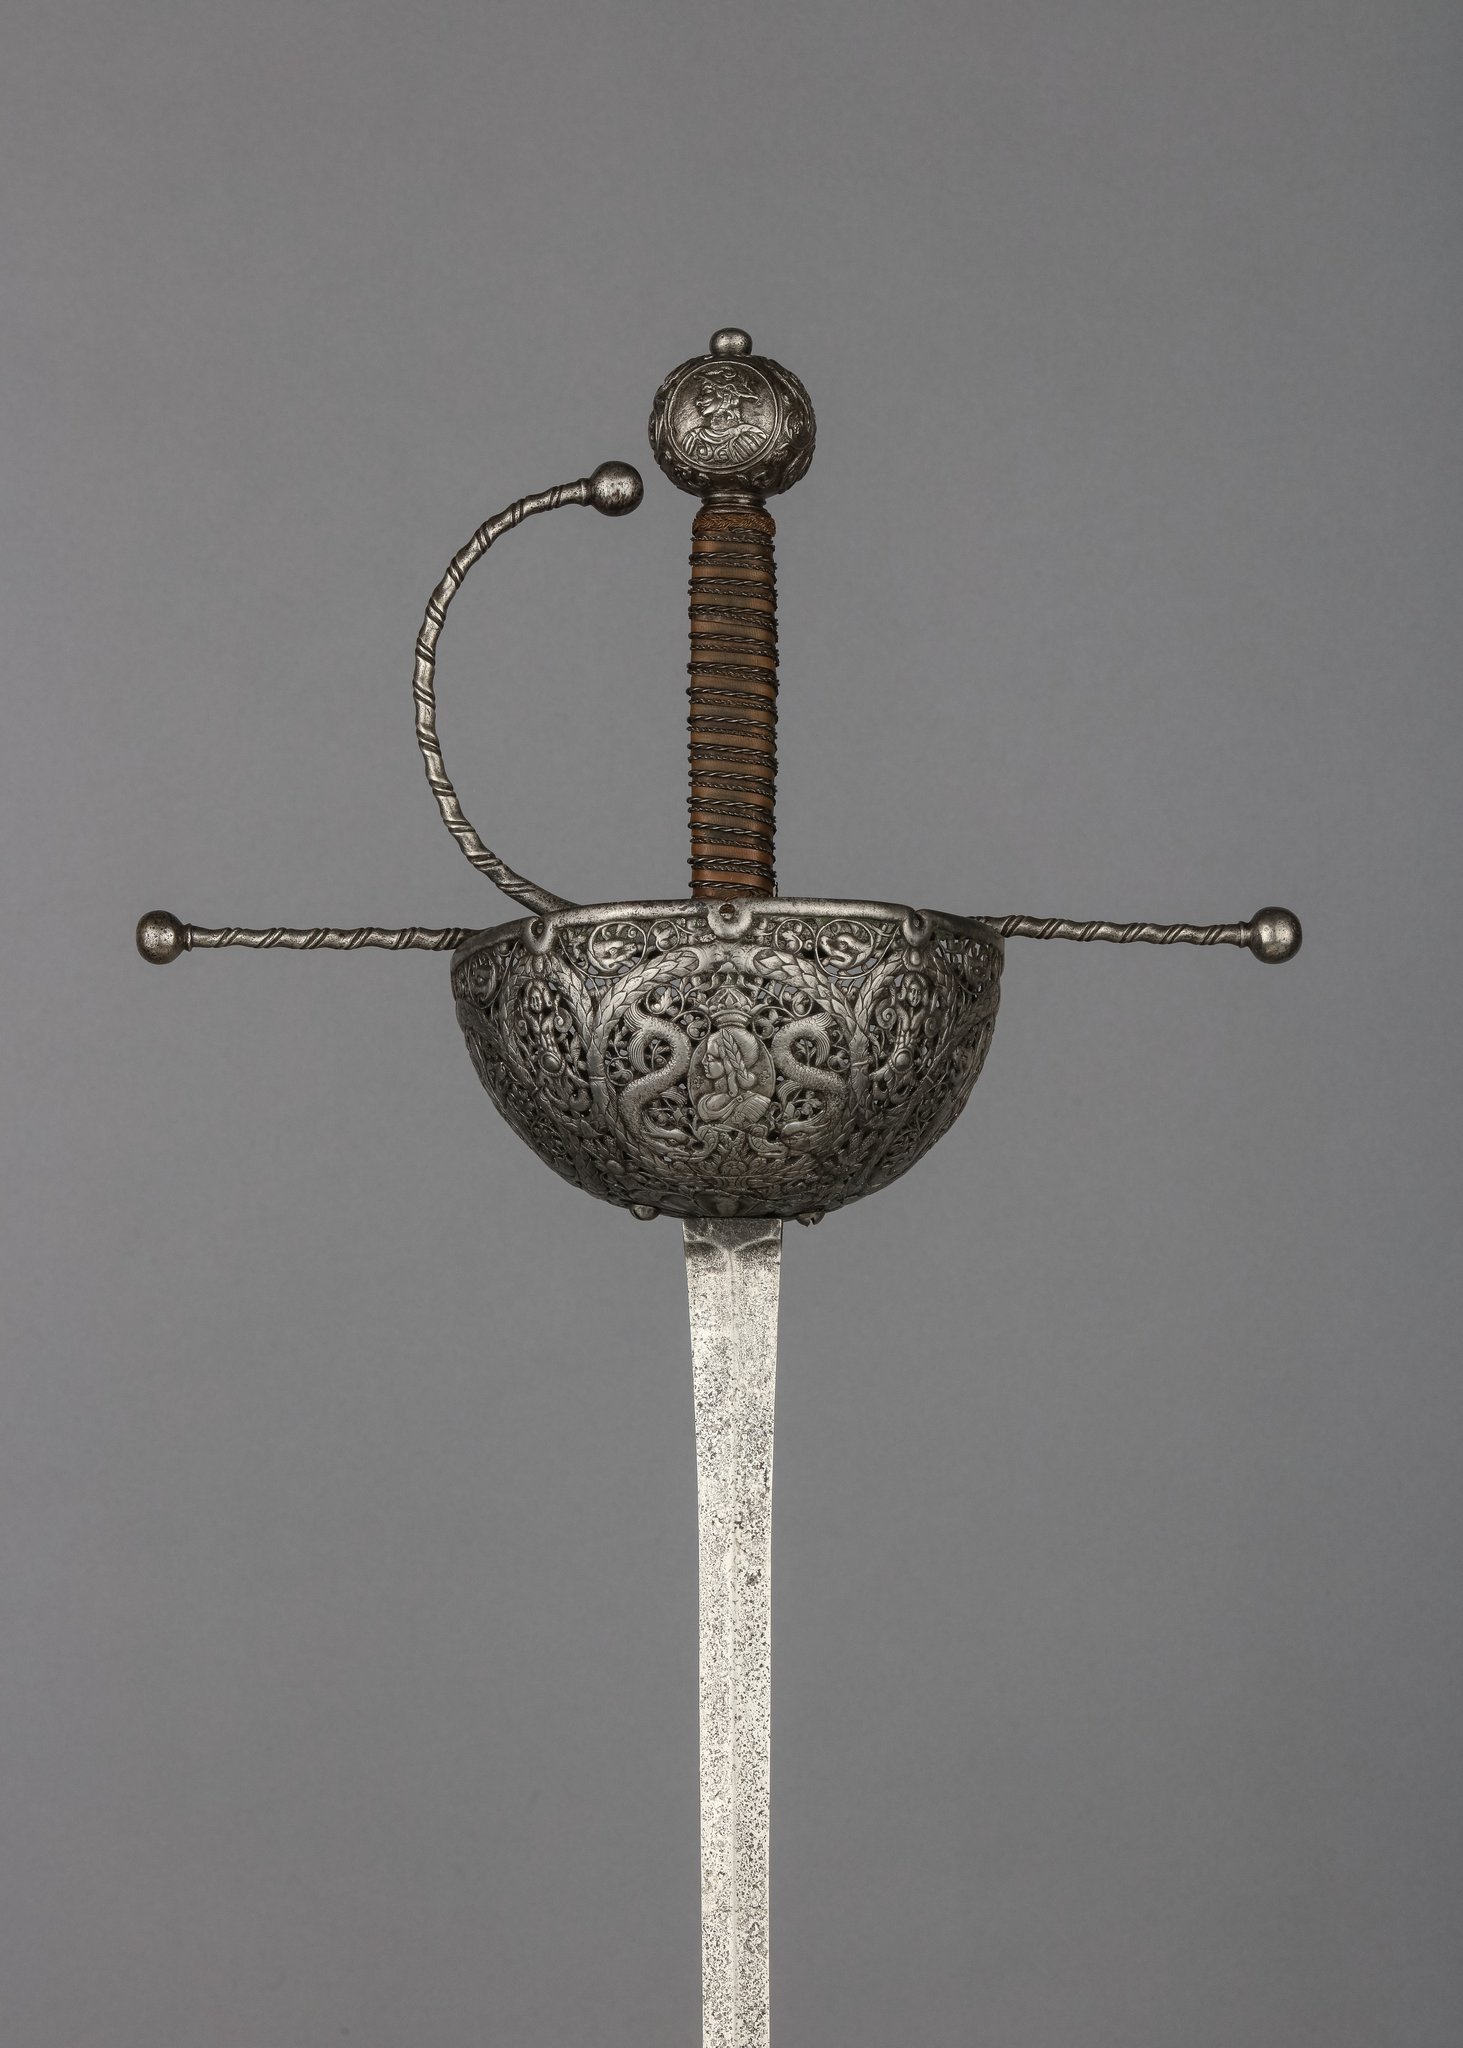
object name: cup hilted rapier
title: Cup-Hilted Rapier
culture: french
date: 1643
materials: brass, steel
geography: france